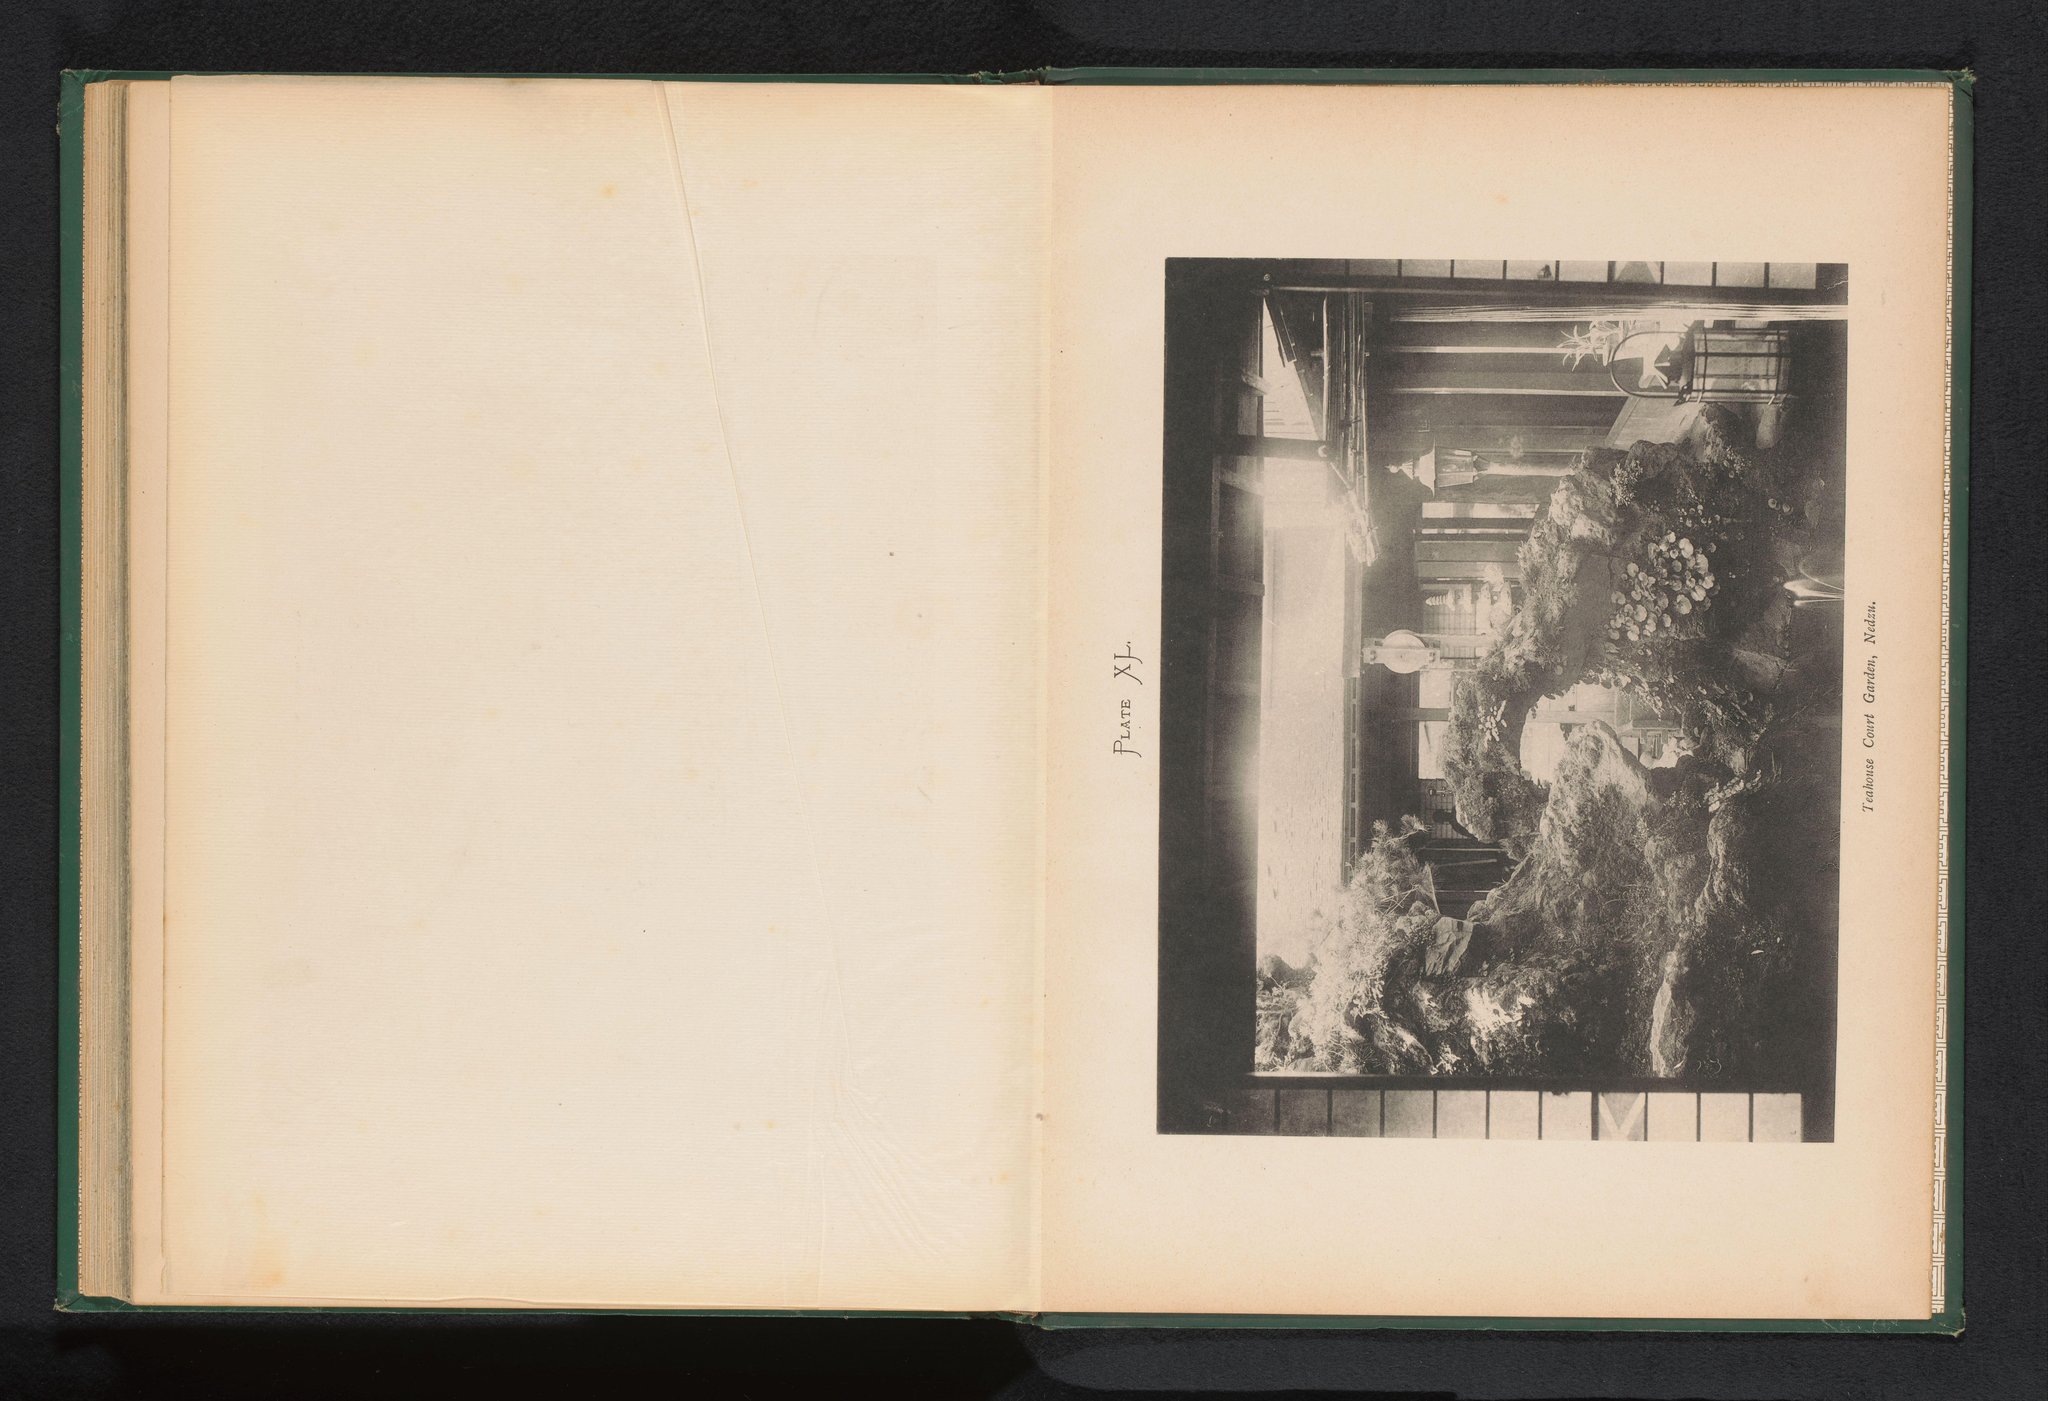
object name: photomechanical print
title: Teahouse Court Garden, Nedzu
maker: kazumasa ogawa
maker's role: auteur, fotograaf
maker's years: 1860-1929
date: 1888-1893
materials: paper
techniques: photograph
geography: japan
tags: rock-garden, courtyard, japan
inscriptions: inscription: ‘Plate XL.’